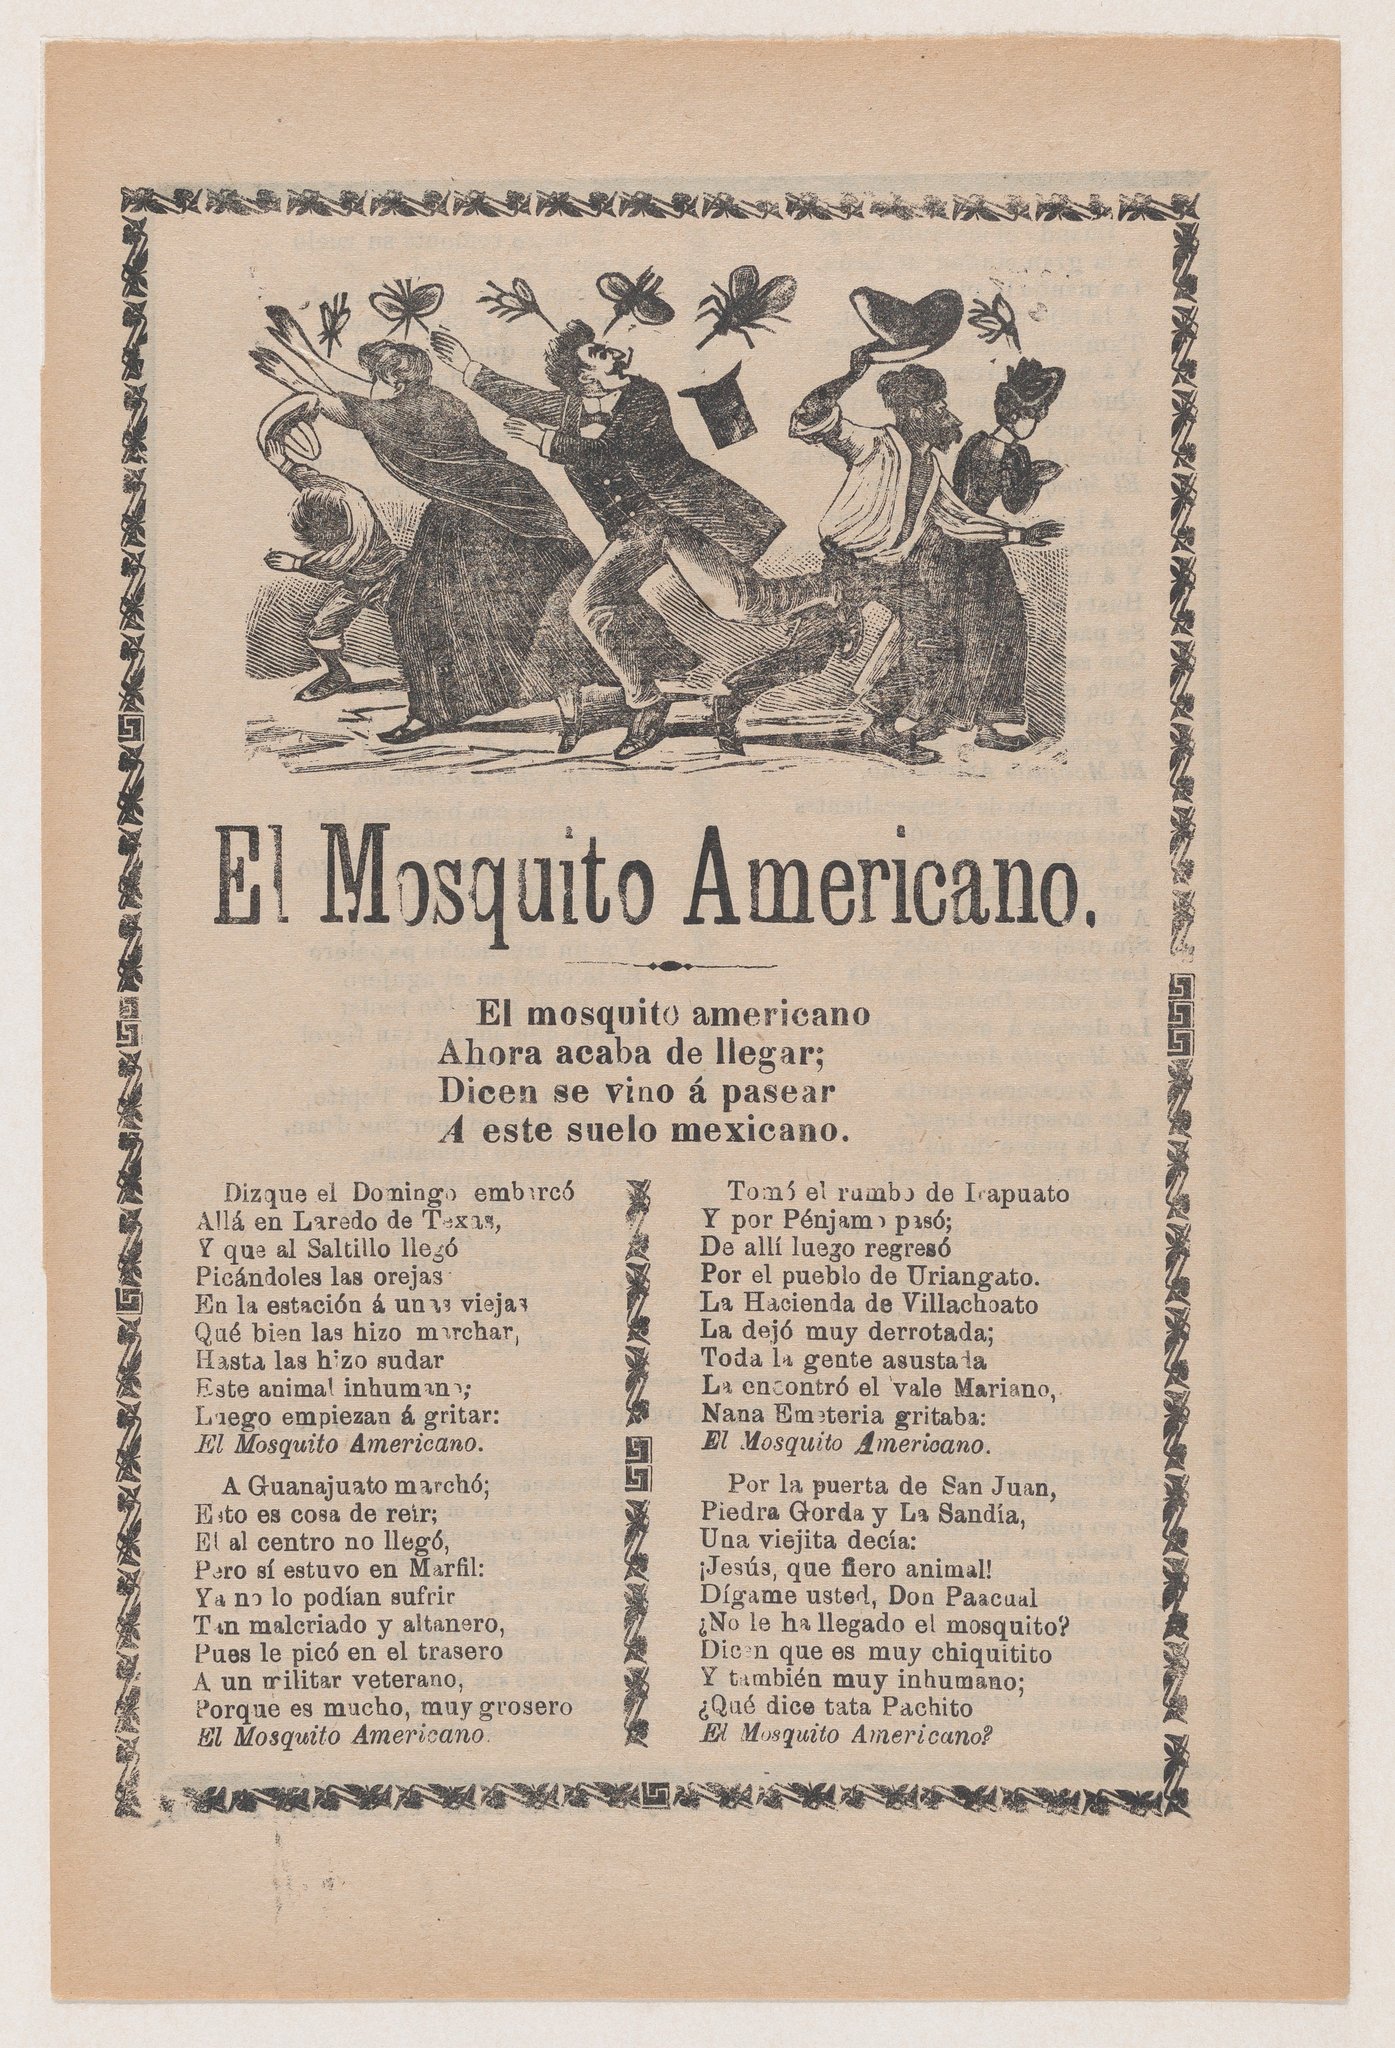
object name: print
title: Broadsheet relating to the American Mosquito with verse critical of U.S. imperialism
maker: josé guadalupe posada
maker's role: artist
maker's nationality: mexican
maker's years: 1852-1913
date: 1908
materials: metal, paper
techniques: engraving, letterpress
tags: men,women,insects